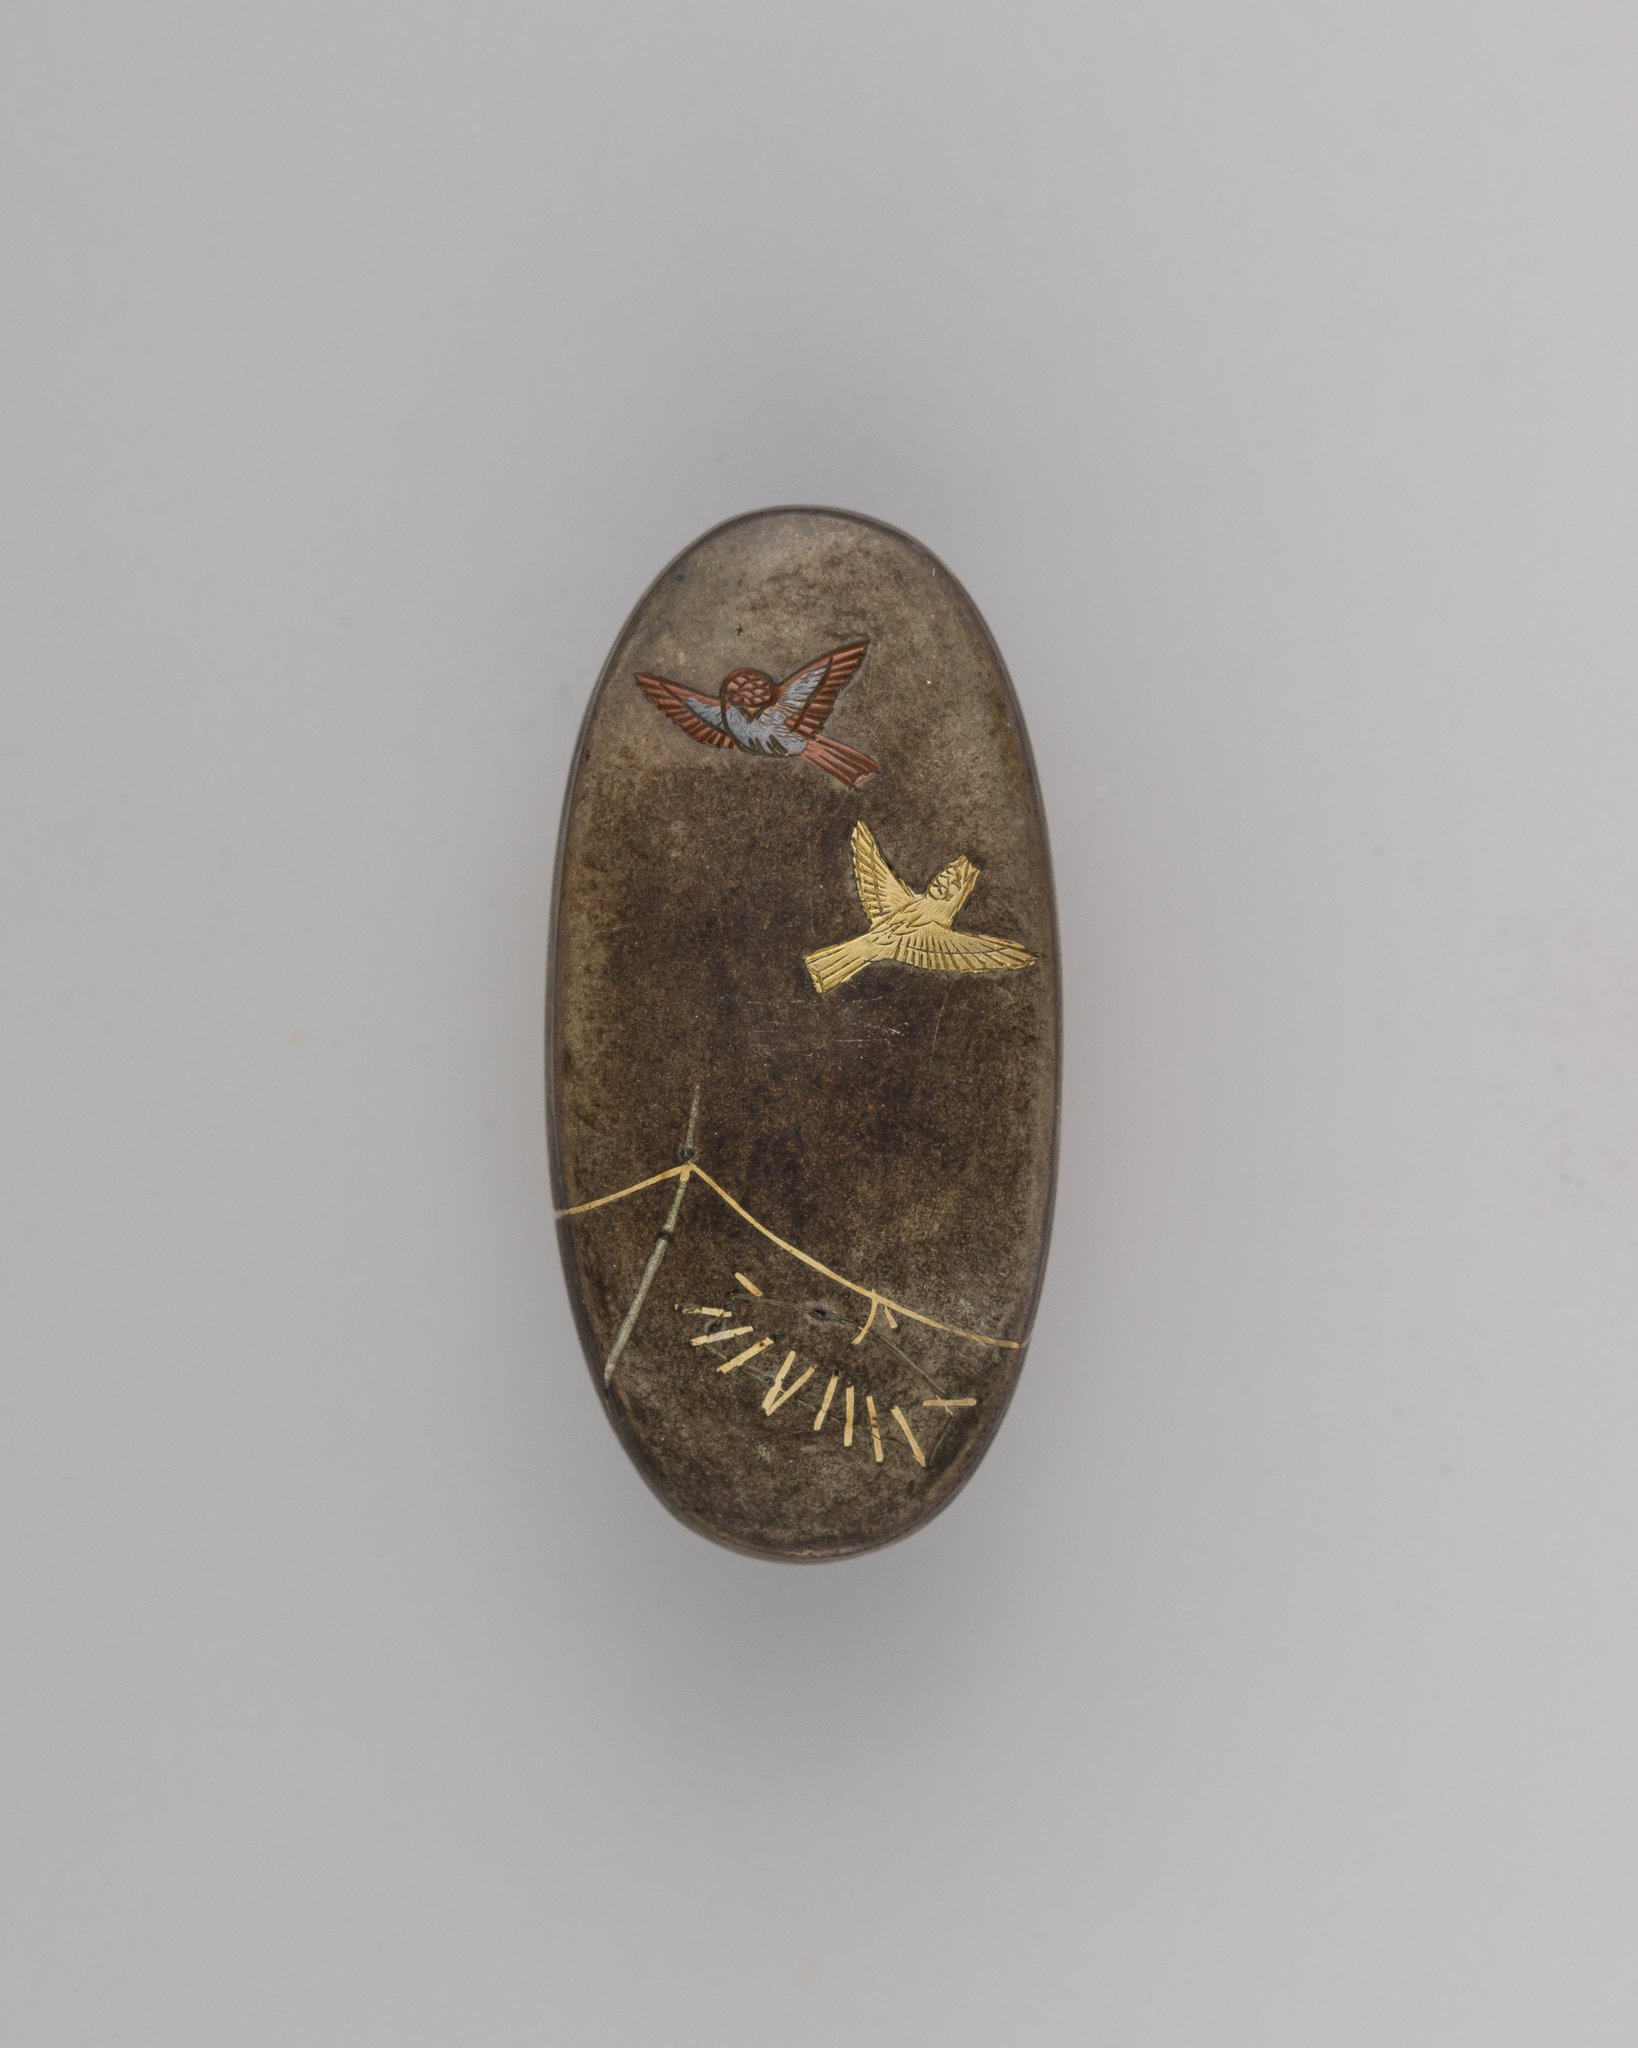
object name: scabbard chape kojiri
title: Scabbard Chape (Kojiri)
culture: japanese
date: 1801-1900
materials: copper, silver alloy, gold, silver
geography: japan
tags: birds